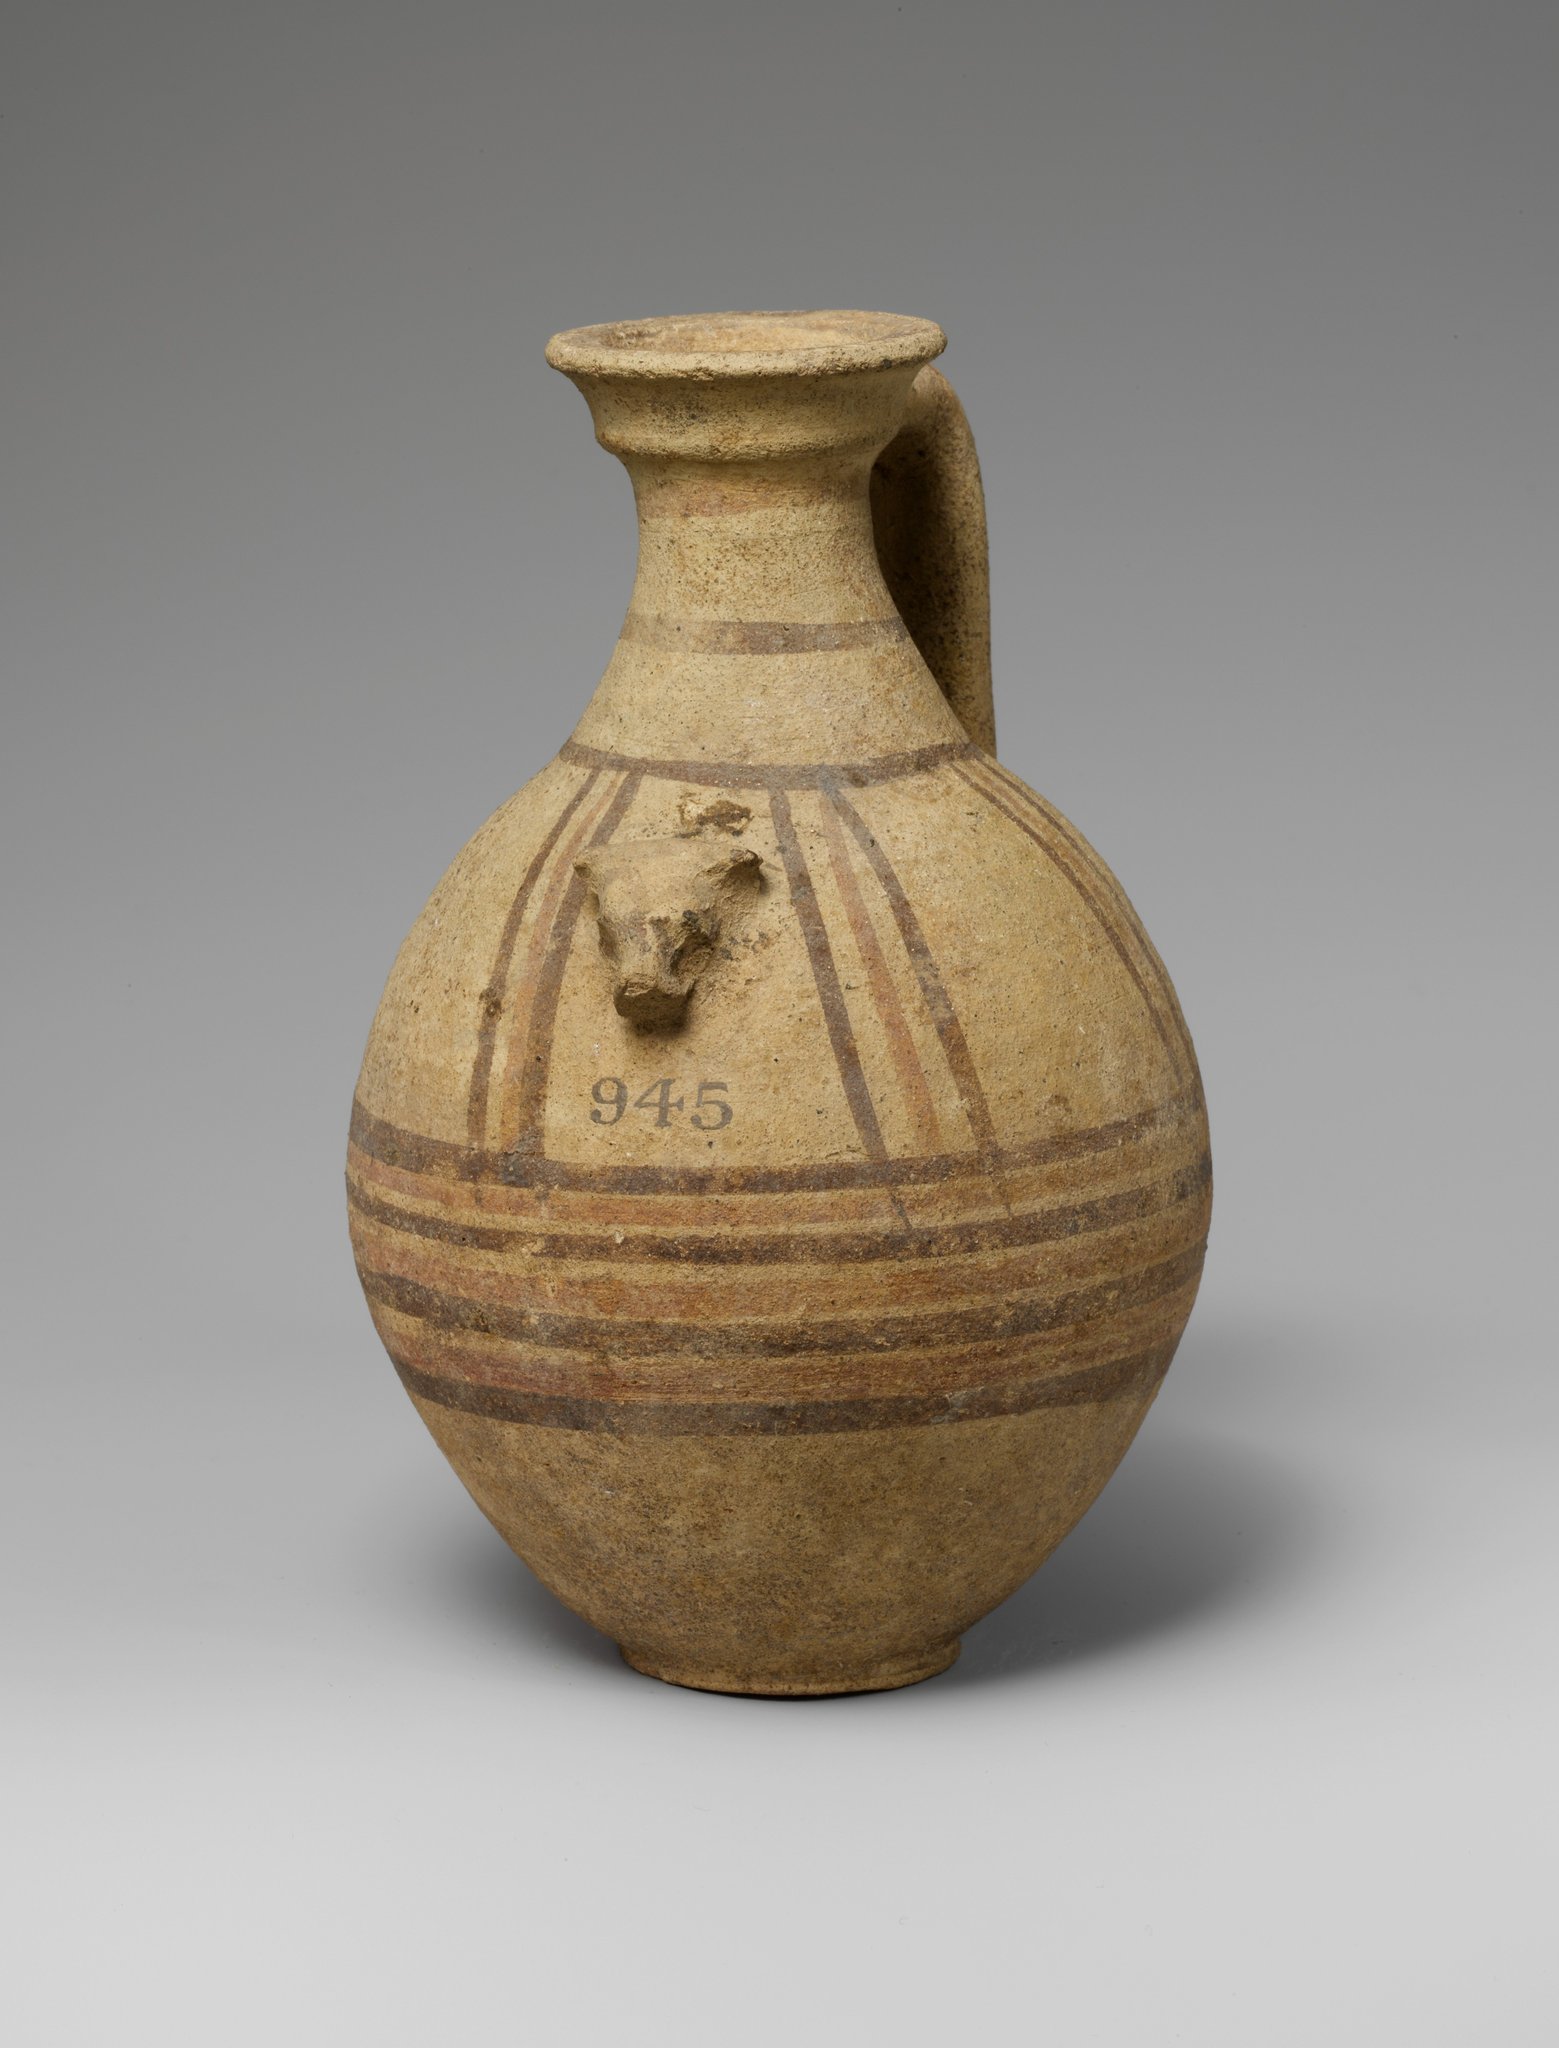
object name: jug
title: Terracotta jug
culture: cypriot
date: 600-400 BCE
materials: terracotta